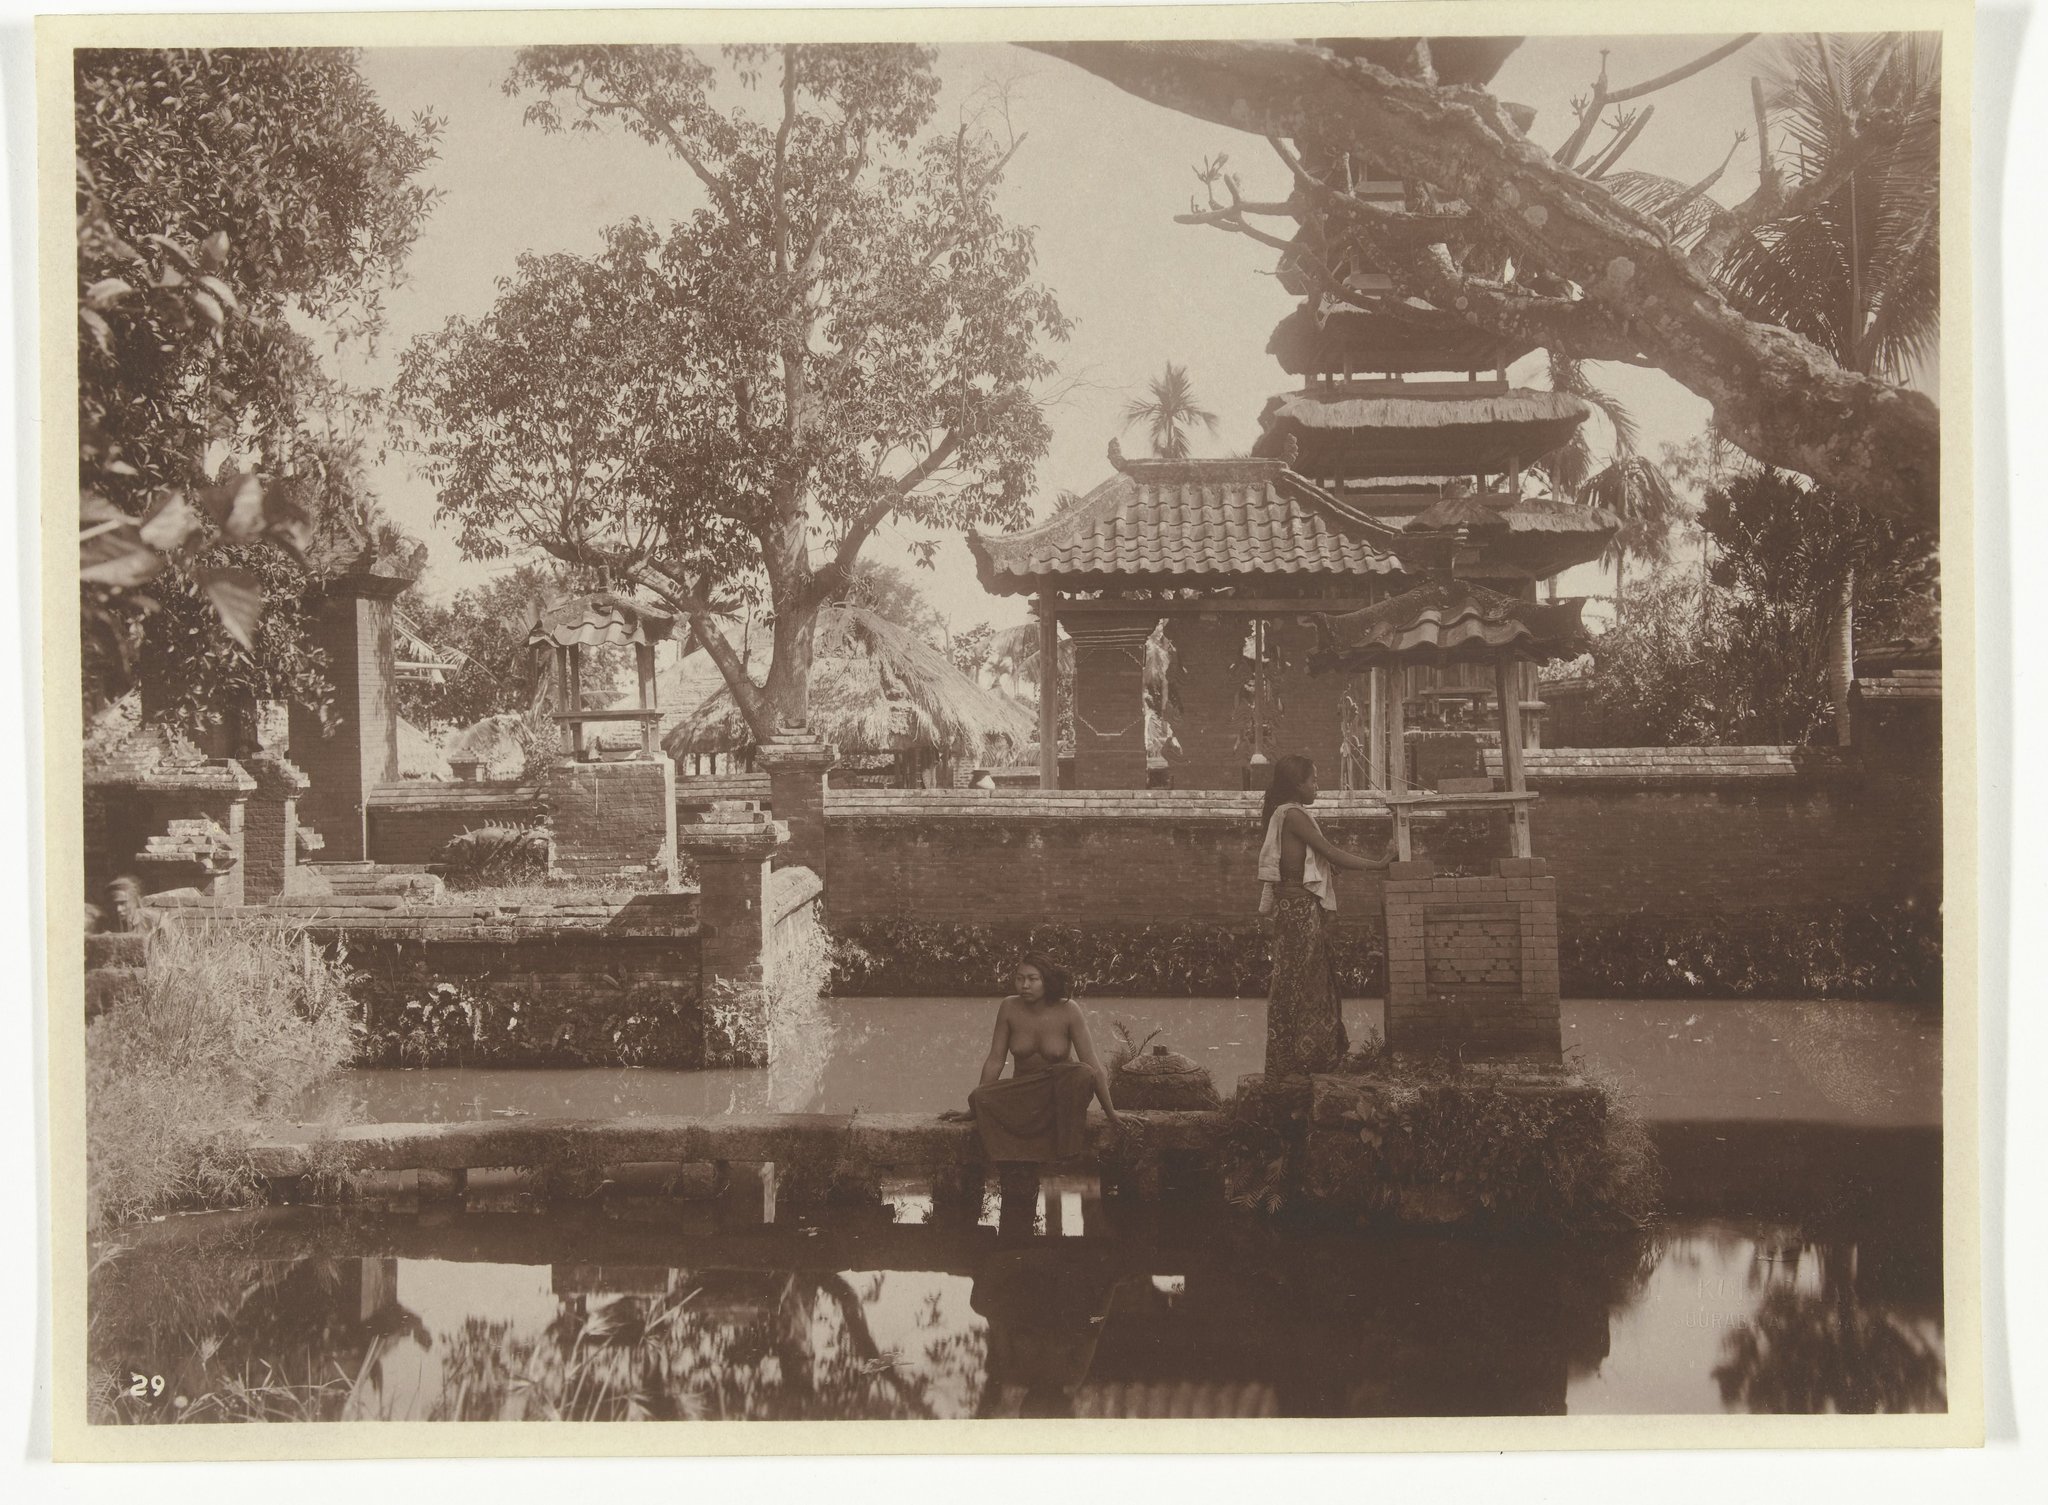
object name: photograph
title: Offerplaats op Bali, voormalig Nederlands-Indië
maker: onnes kurkdjian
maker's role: fotograaf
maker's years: 1851-1903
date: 1890-1911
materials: paper, photographic support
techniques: gelatin silver print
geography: dutch east indies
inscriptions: stamp: ‘Foto Kurkdjian, Soerabaia (...)’, number: ‘29’, check stamp: ‘Kurkdjian / Sourabaia Java’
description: Twee vrouwen met naakt bovenlichaam bij een offerplaats gelegen aan water op Bali, voormalig Nederlands-Indië